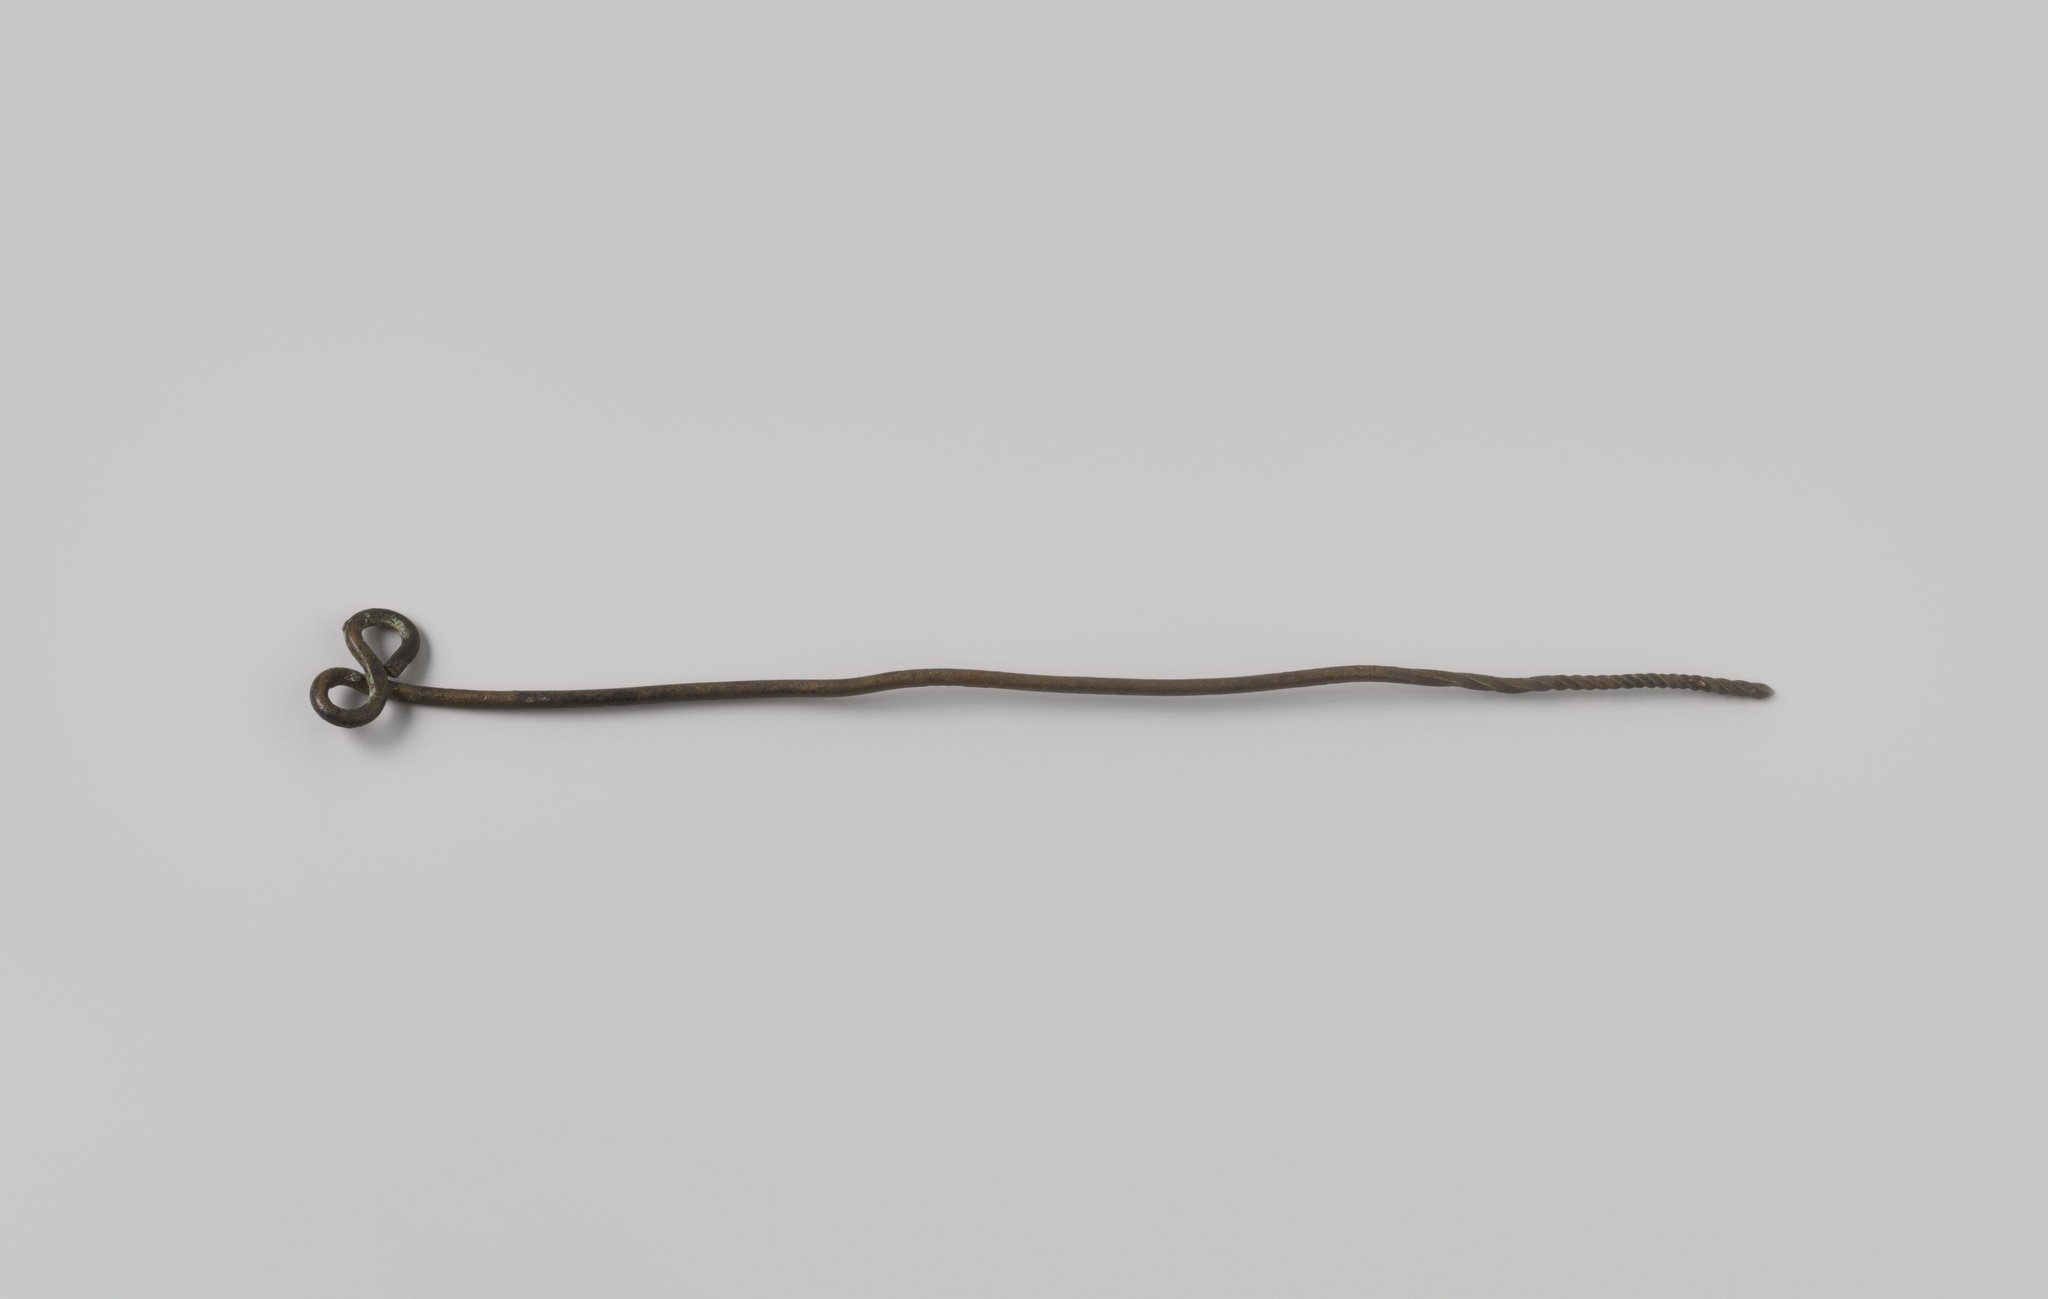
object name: priming wire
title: Laadpriem uit het wrak van de Oost-Indiëvaarder Hollandia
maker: Anonymous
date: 1700-1743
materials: copper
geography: netherlands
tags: verenigde oostindische compagnie, hollandia (schip), annet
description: Priming wire; straight copper wire rod, tapering to a twisted point at the lower end, figure-of-eight-shaped upper end.